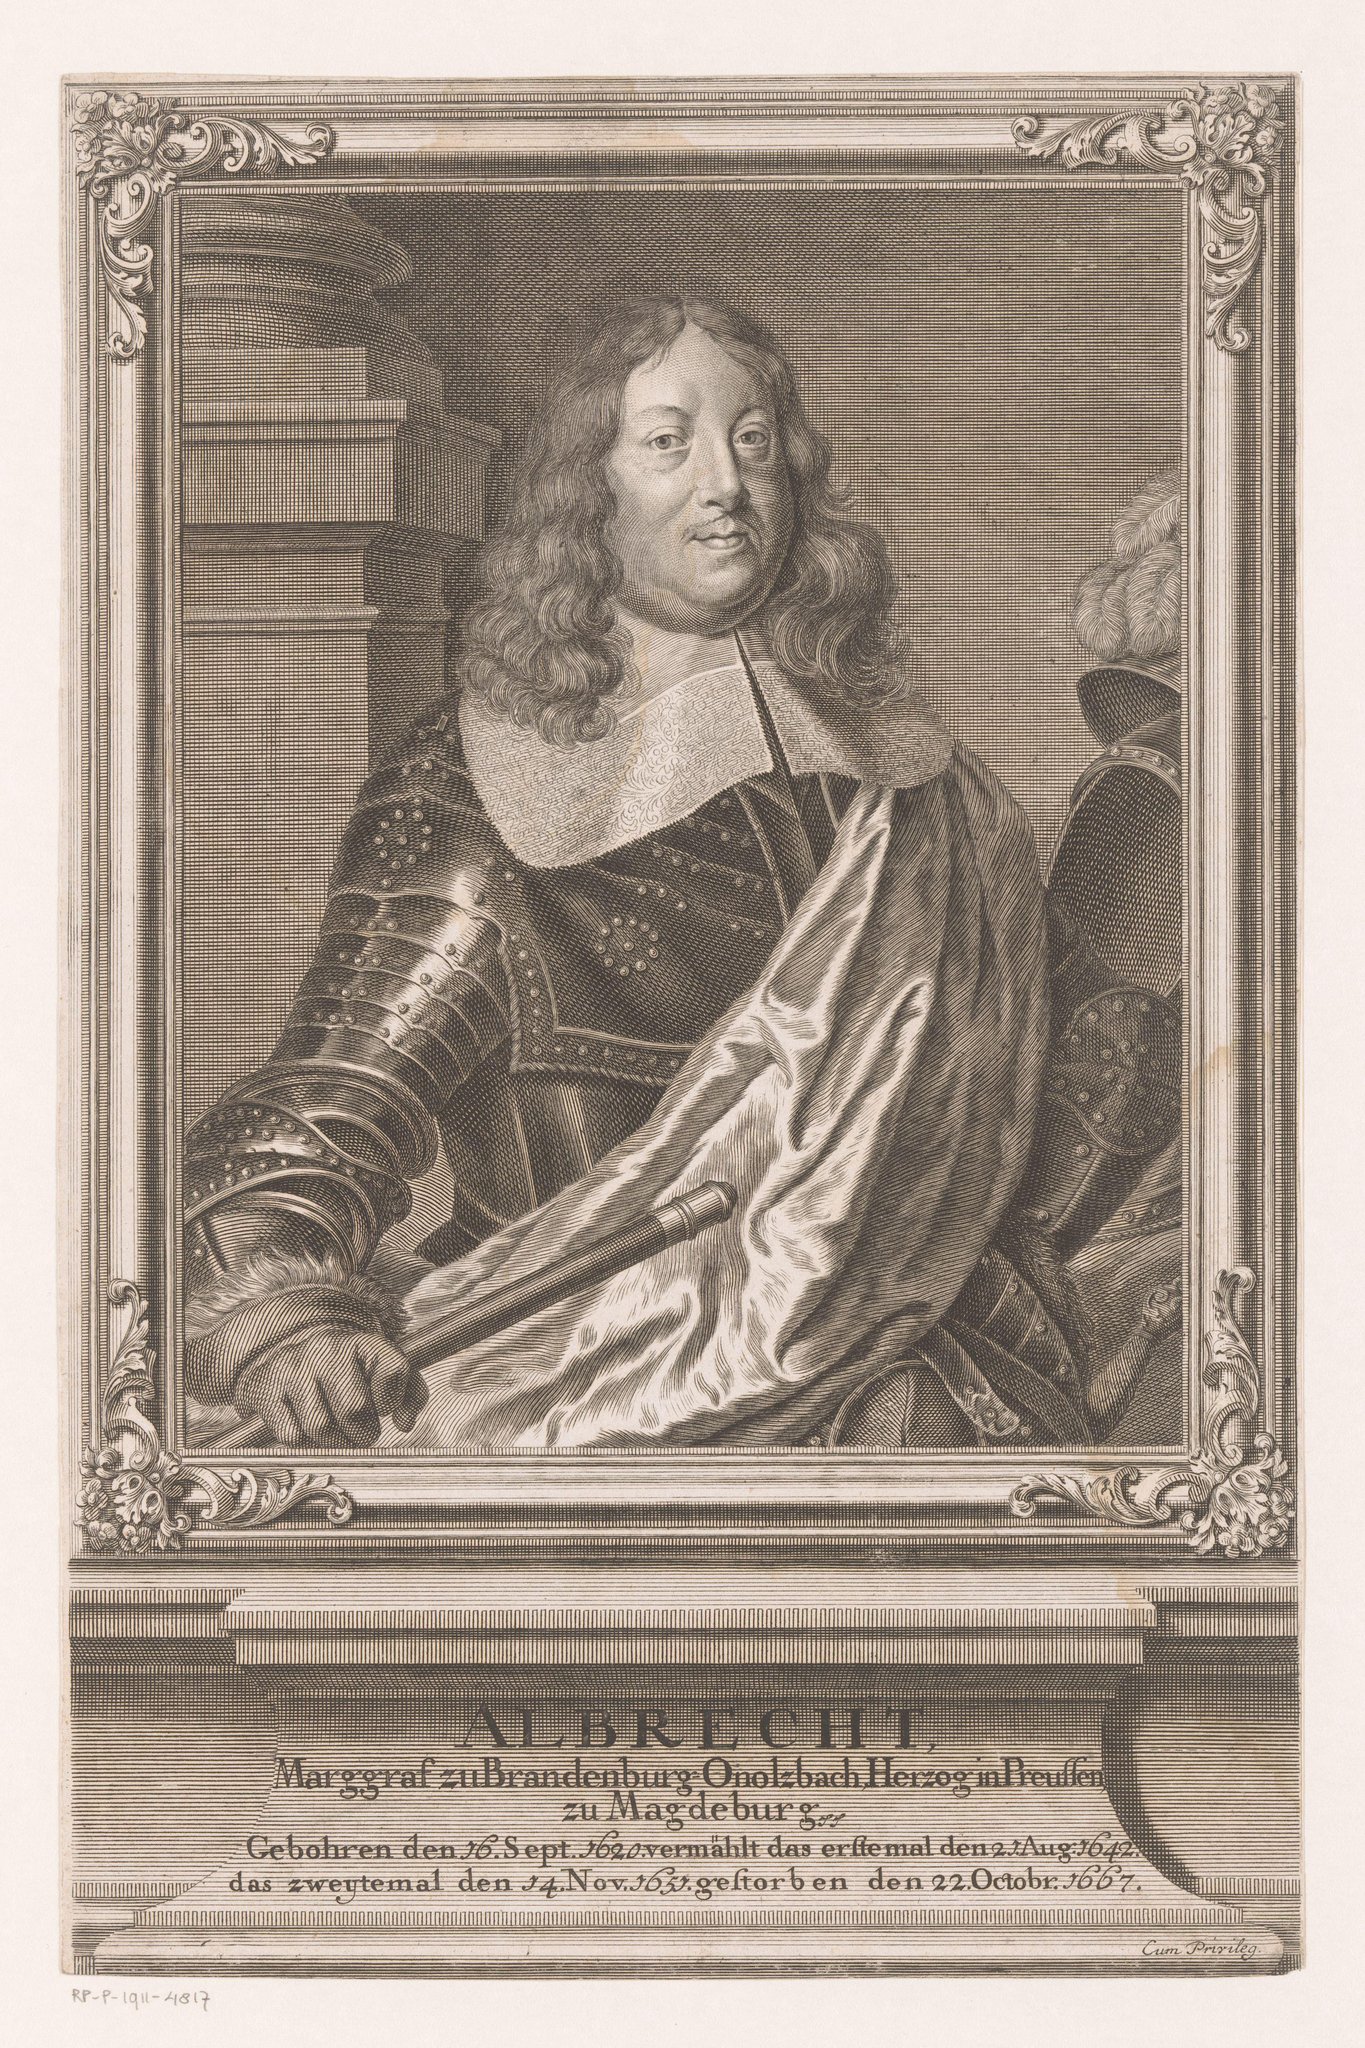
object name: print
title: Portret van Albrecht van Brandenburg-Ansbach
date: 1740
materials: paper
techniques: engraving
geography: germany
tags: historical persons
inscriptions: collector's mark: Lugt 2228